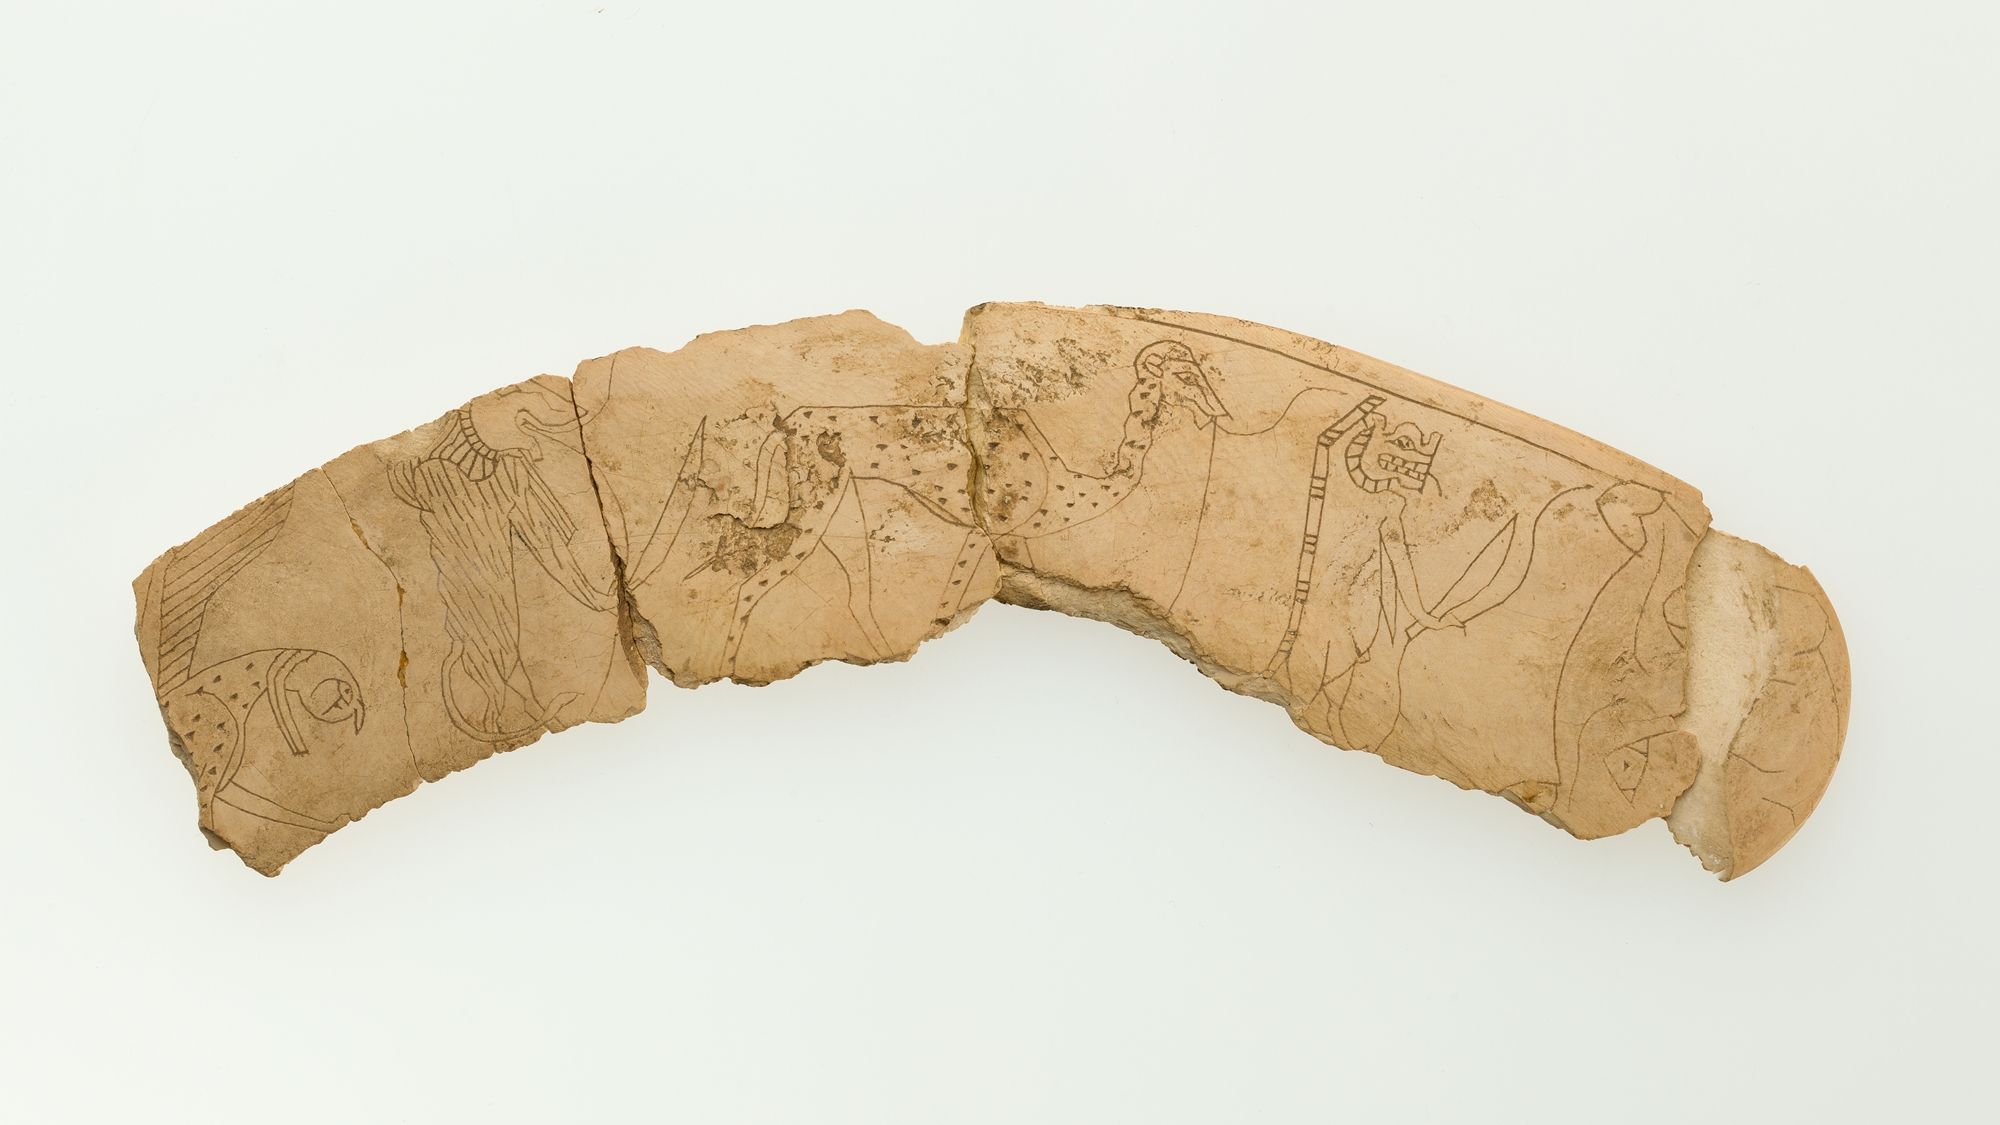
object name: magic wand fragment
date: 1981-1550 BCE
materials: ivory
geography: egypt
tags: animals